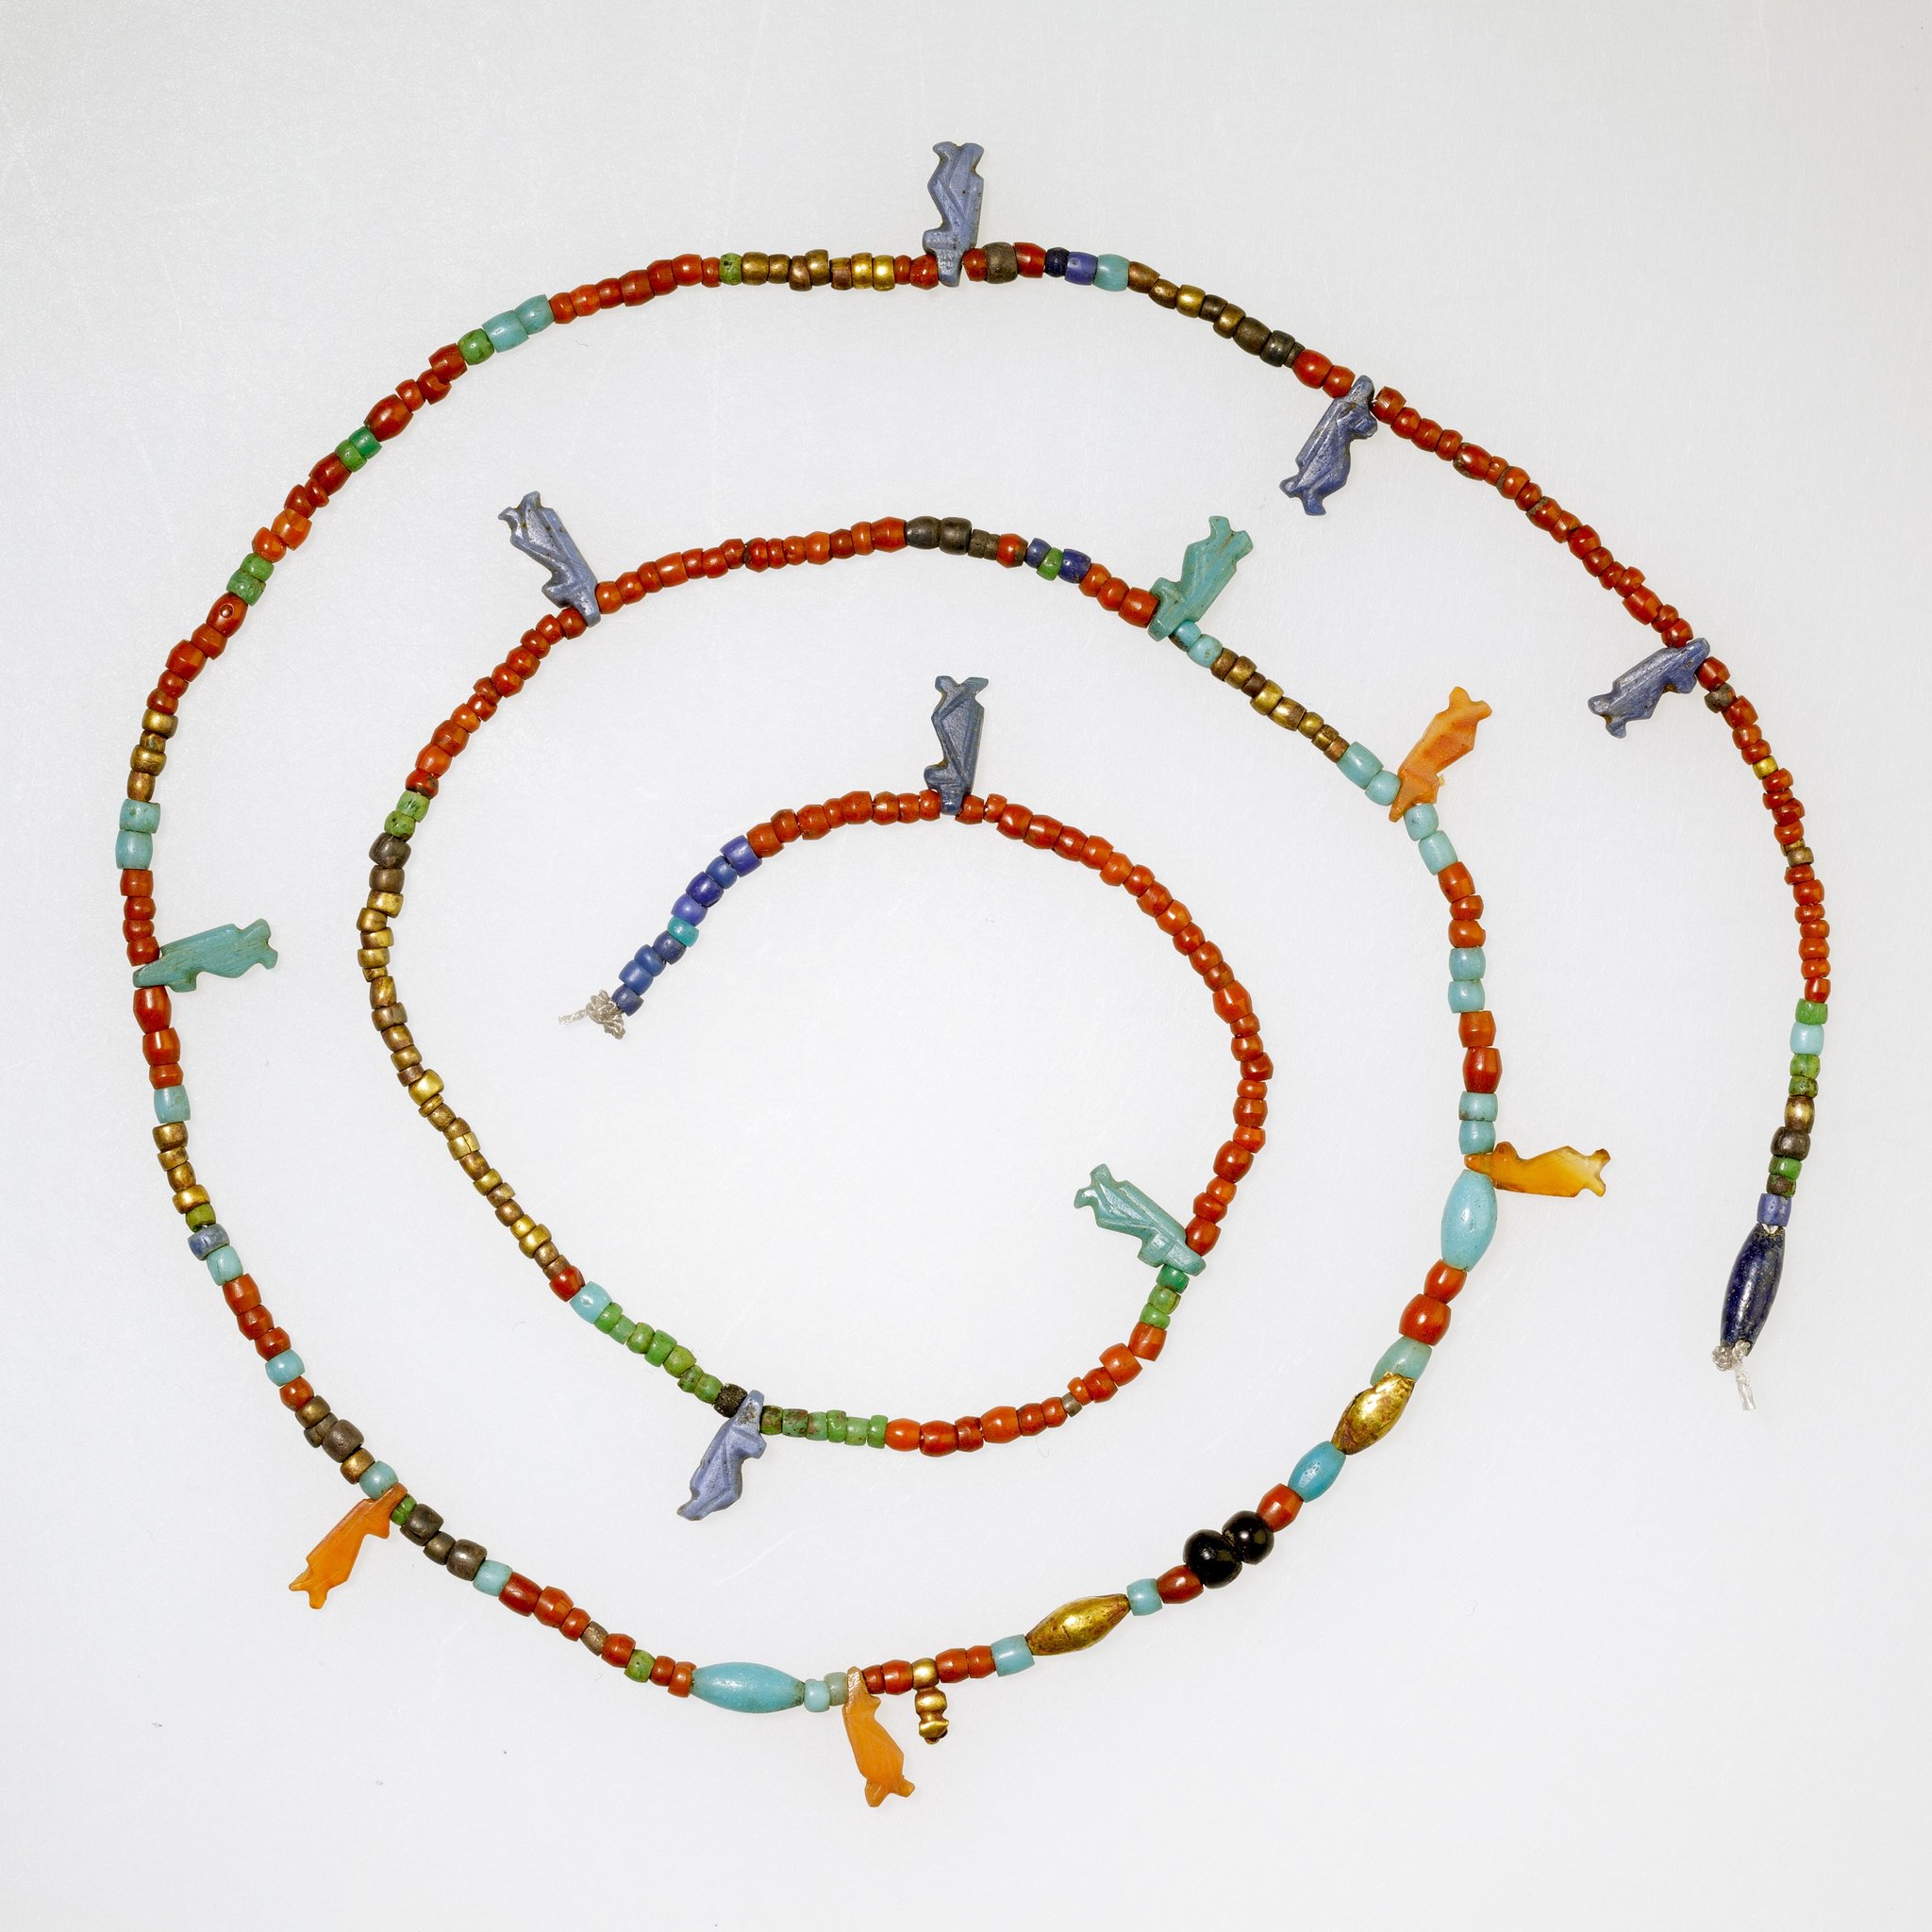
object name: string of tiny disk bead, barrel, and 13 taweret amulet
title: String of tiny disk beads, barrels, and 13 Taweret amulets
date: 1981-1504 BCE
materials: gemstone, glass, gold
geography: egypt